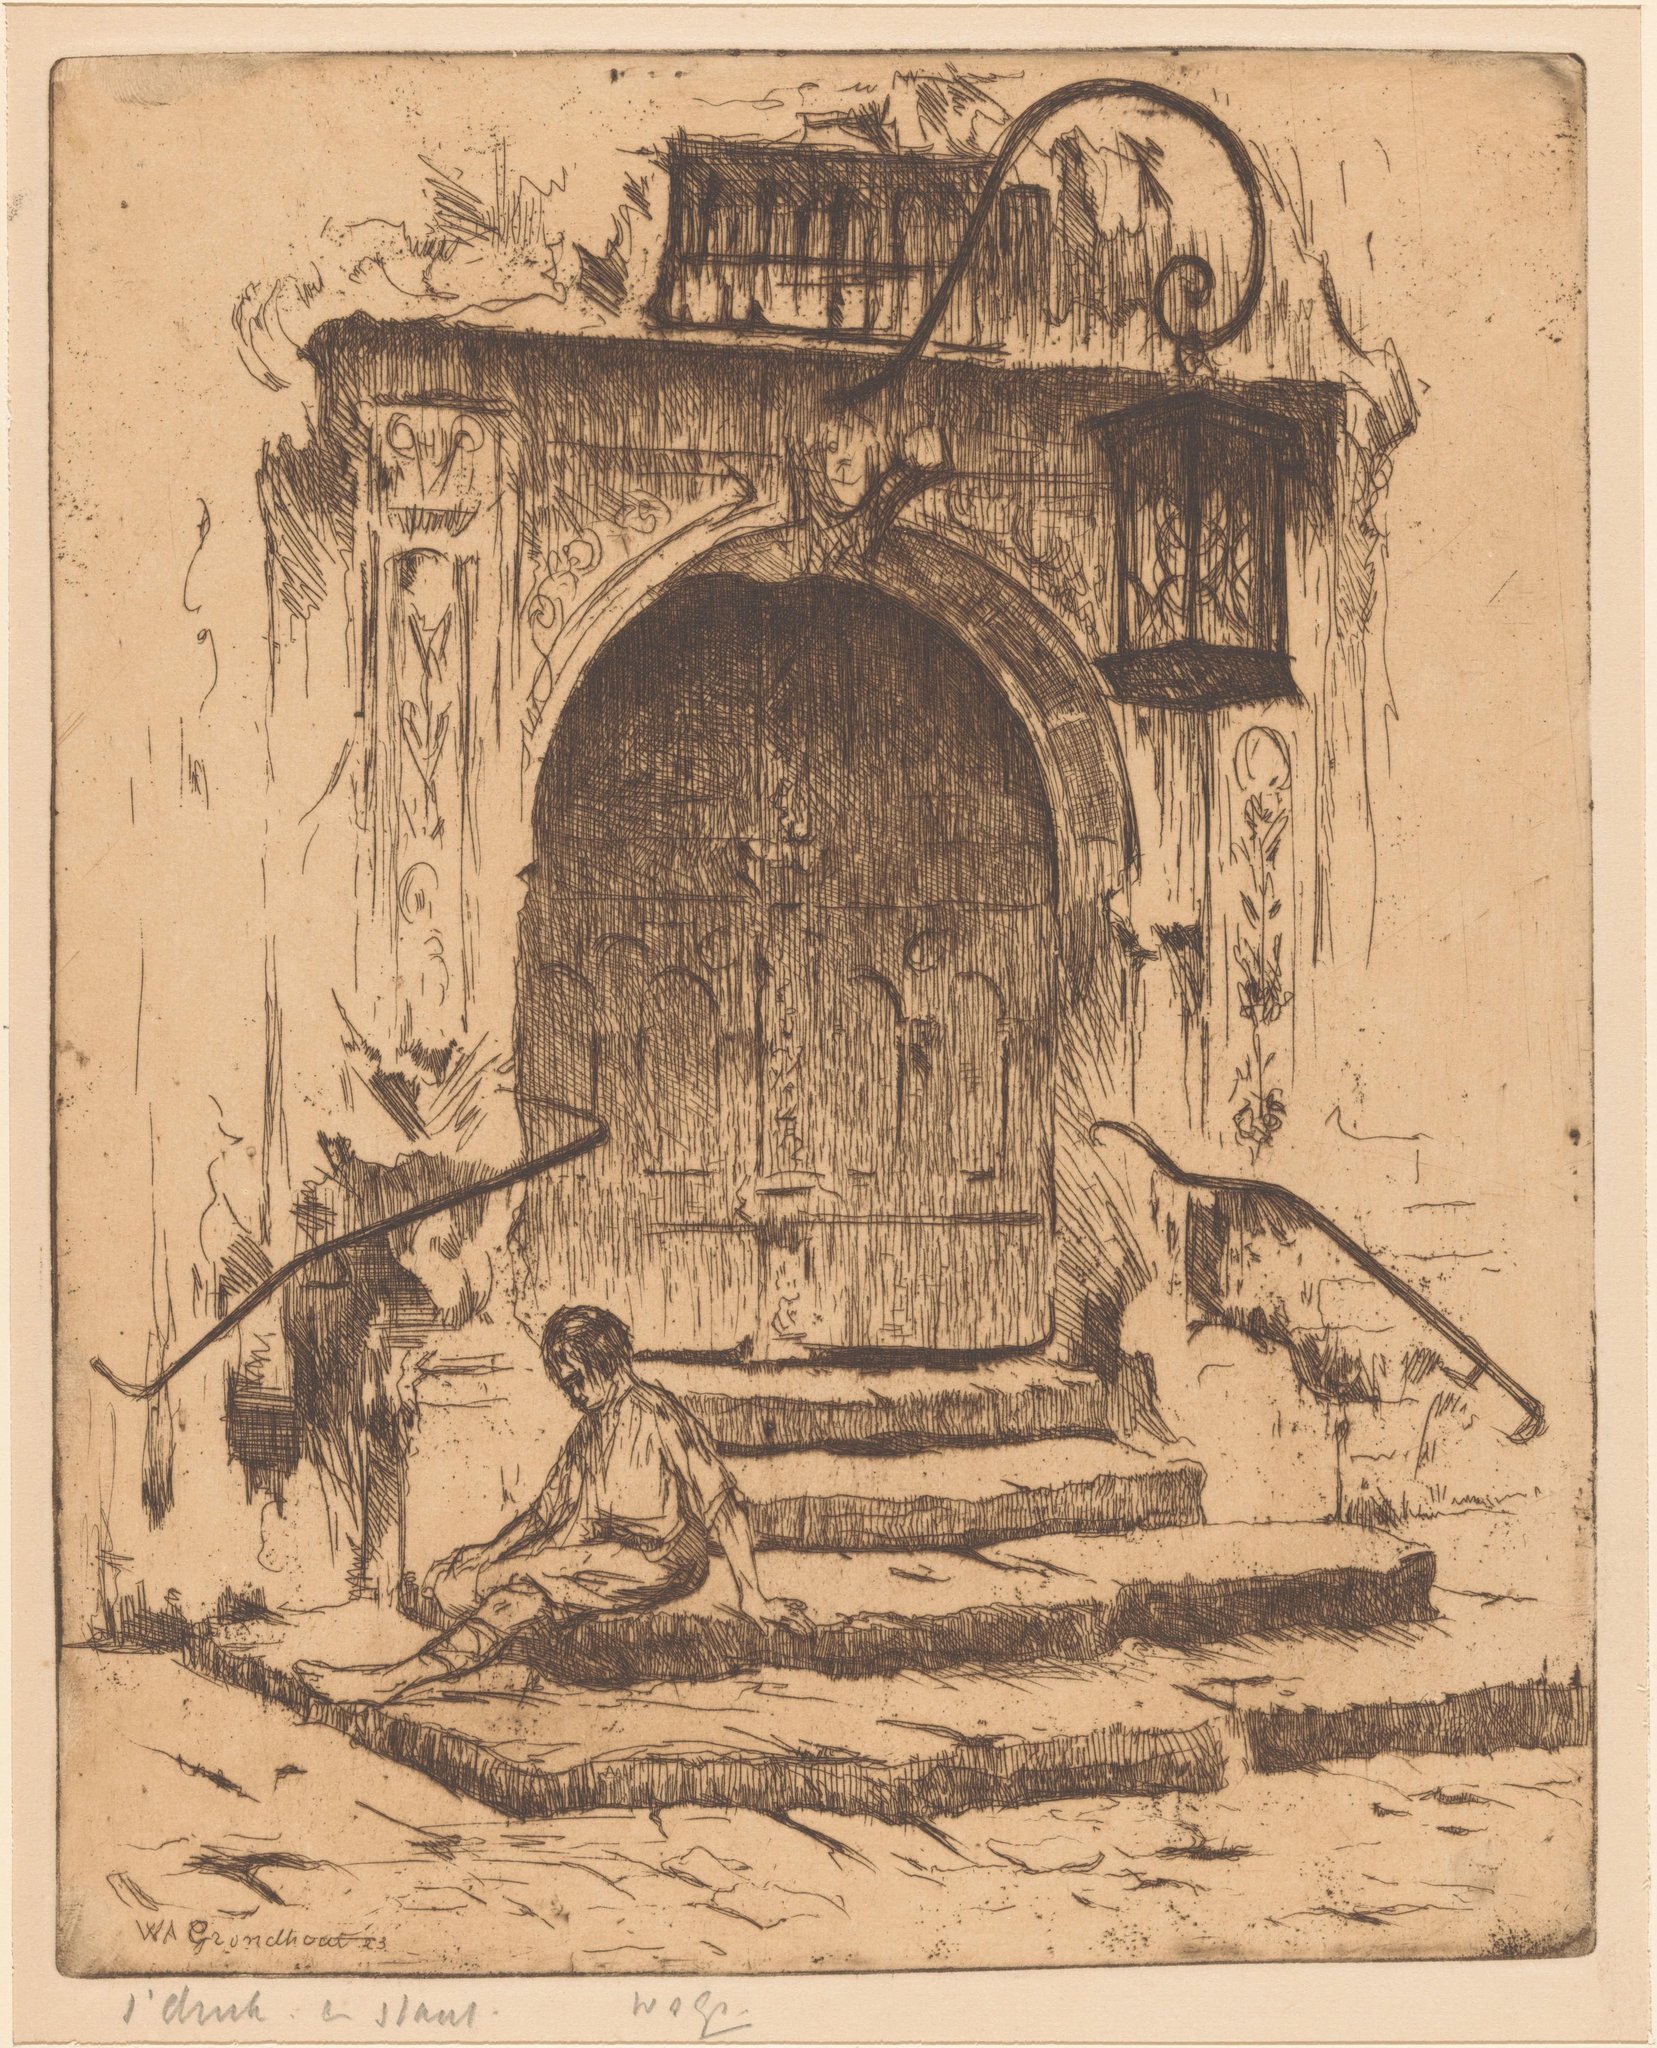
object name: print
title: Poort van het stadhuis in Rothenburg ob der Tauber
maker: willem adrianus grondhout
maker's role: draughtsman, painter, print maker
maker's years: 1878-1934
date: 1888-1934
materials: paper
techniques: etching, intaglio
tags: gate, entrance, townhall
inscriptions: collector's mark: Lugt 2228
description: Op de treden richting de poort zit een figuur. Boven de poort hangt een lantaarn.